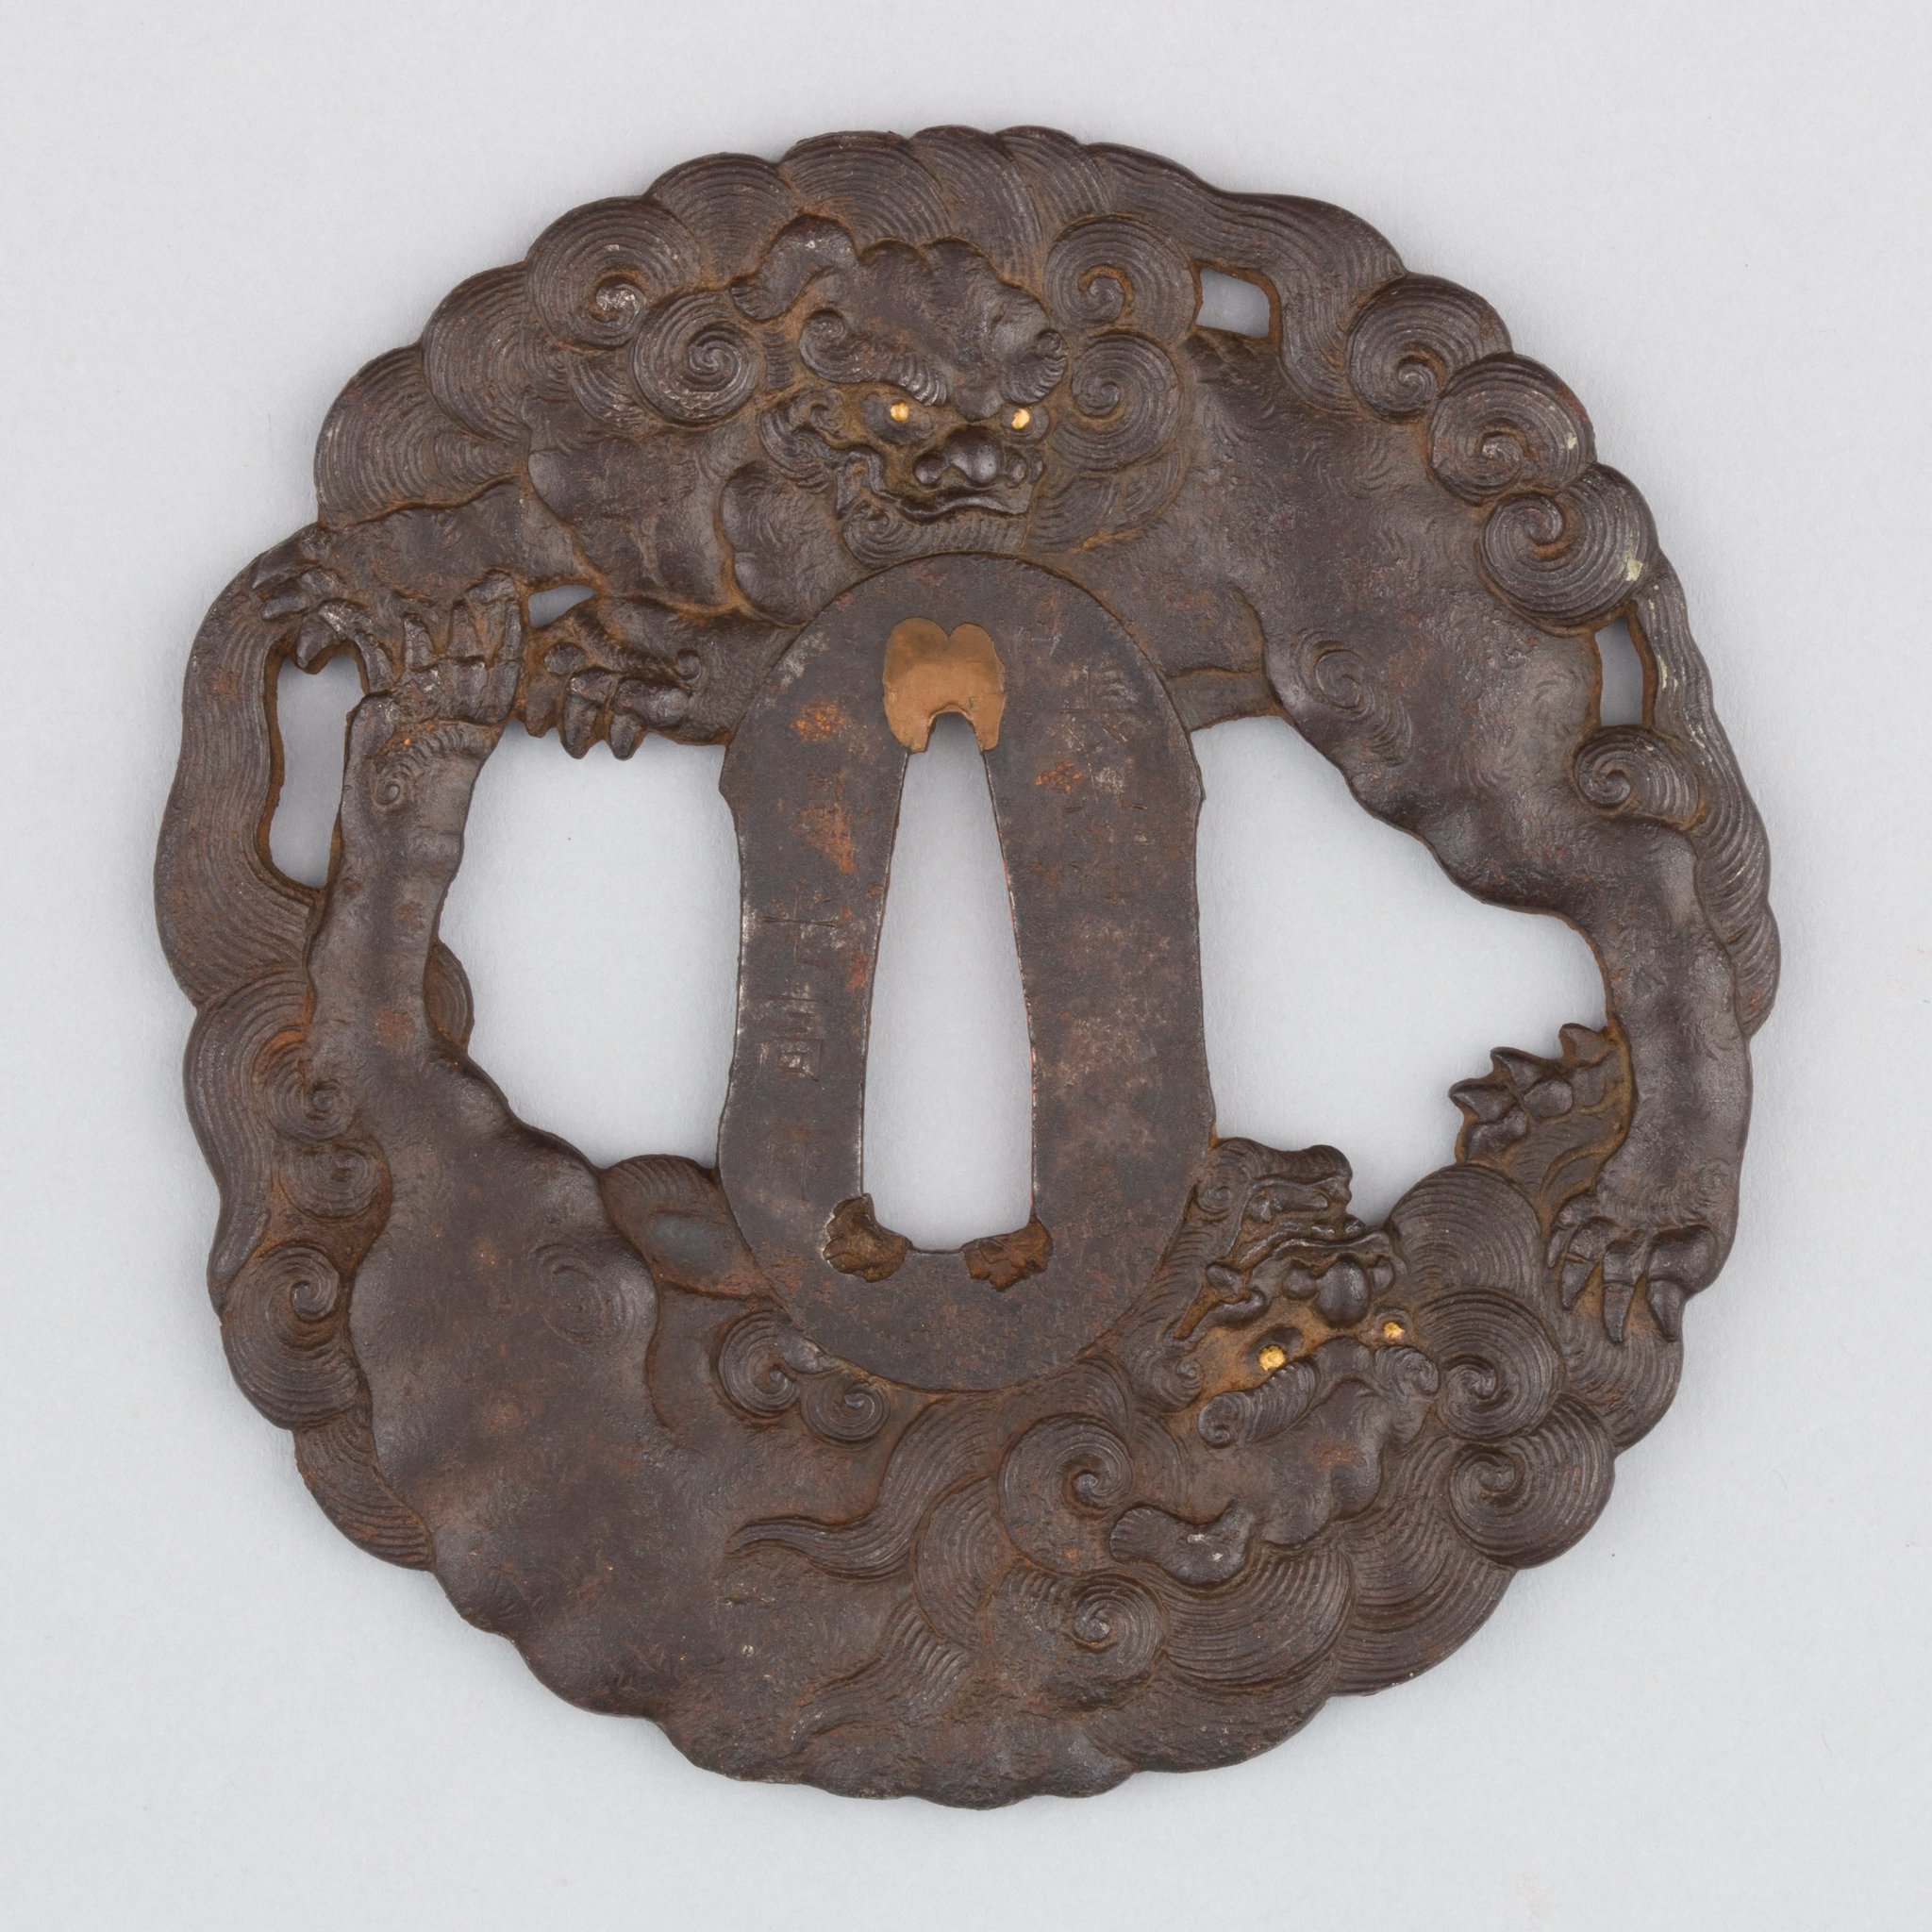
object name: sword guard tsuba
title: Sword Guard (Tsuba)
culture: japanese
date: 1615-1868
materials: copper, iron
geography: japan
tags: lions